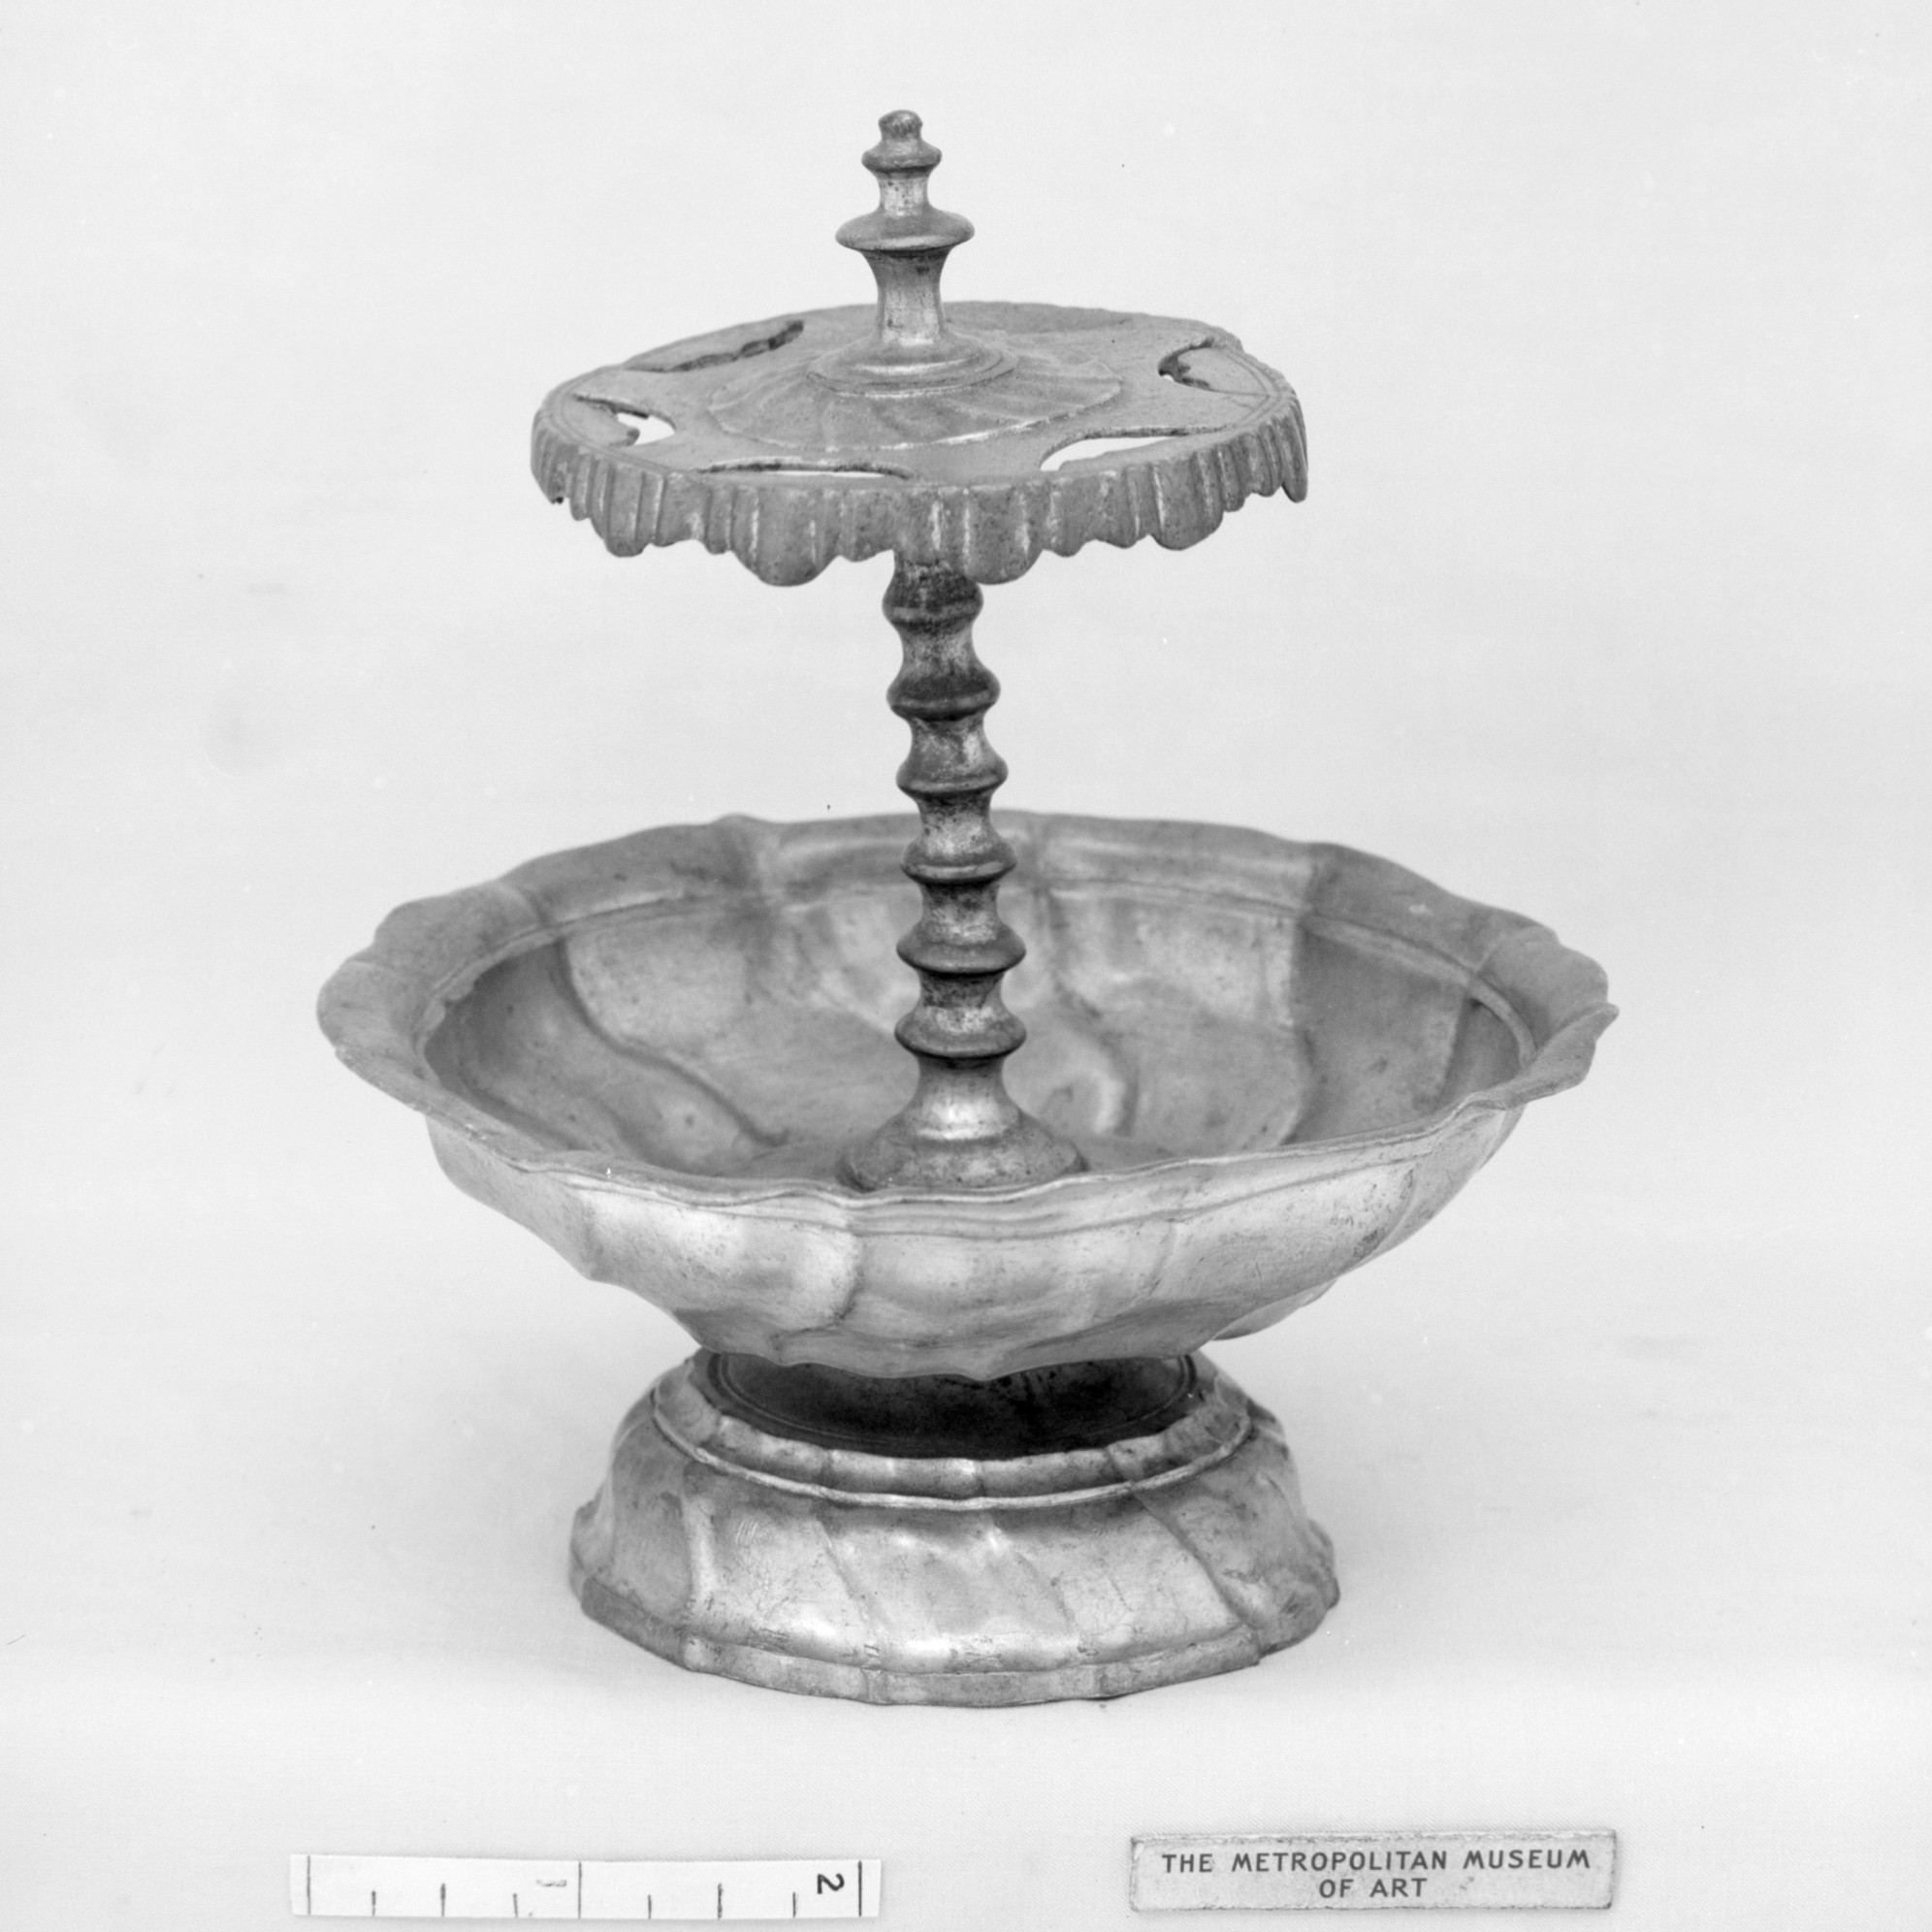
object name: egg stand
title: Egg-stand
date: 1701-1800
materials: pewter